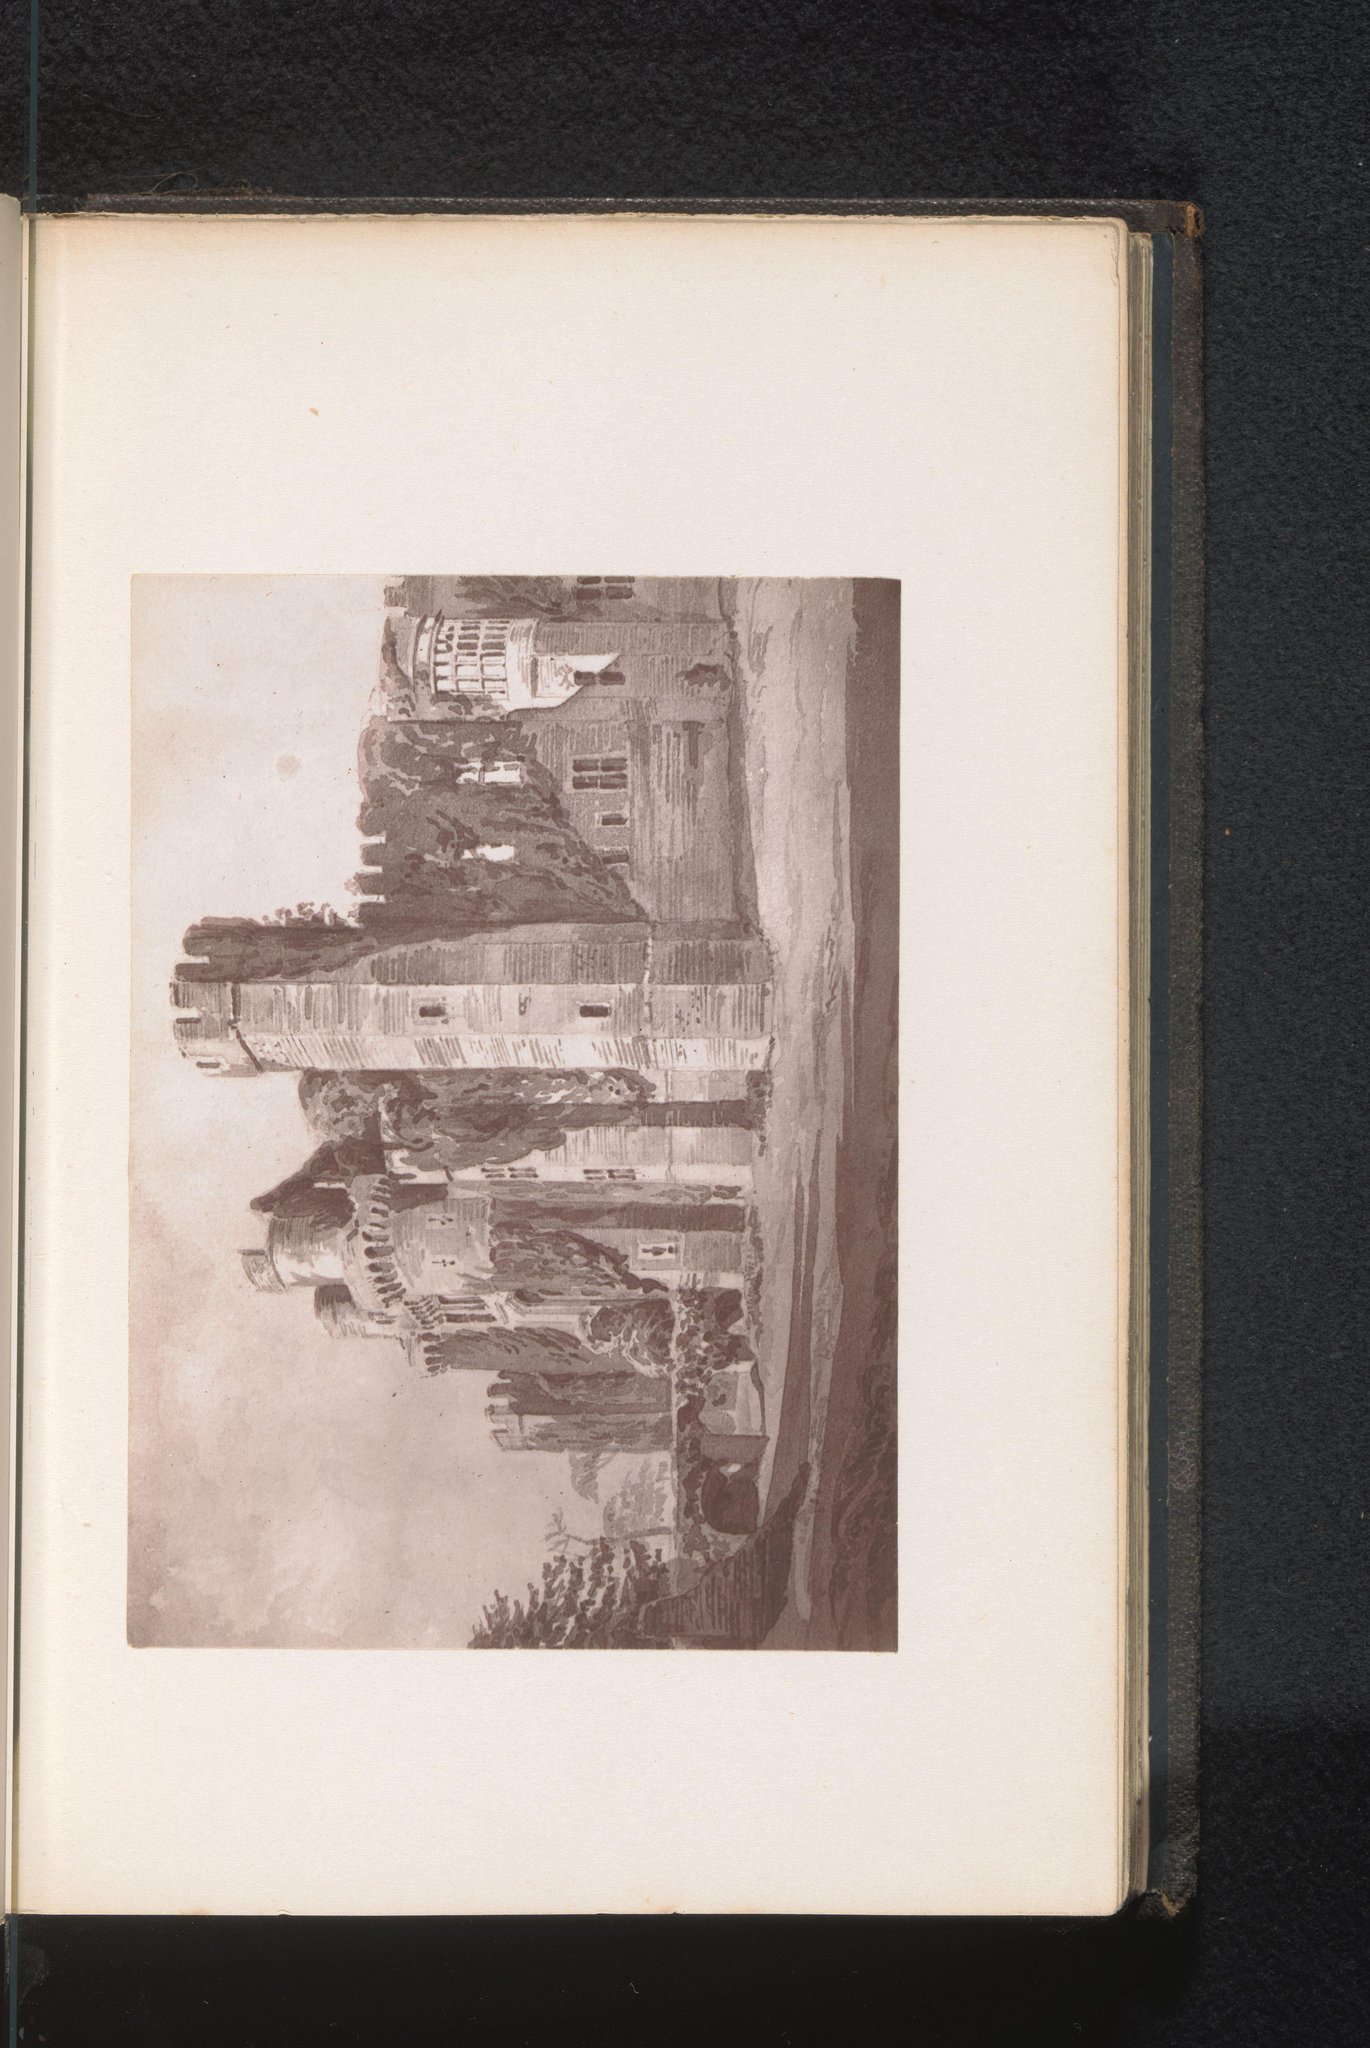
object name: reproduction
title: Fotoreproductie van een schildering, voorstellende een gezicht op Herstmonceux Castle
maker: Anonymous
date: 1866-1876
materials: paper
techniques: woodburytype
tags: castle, façade (of house or building)